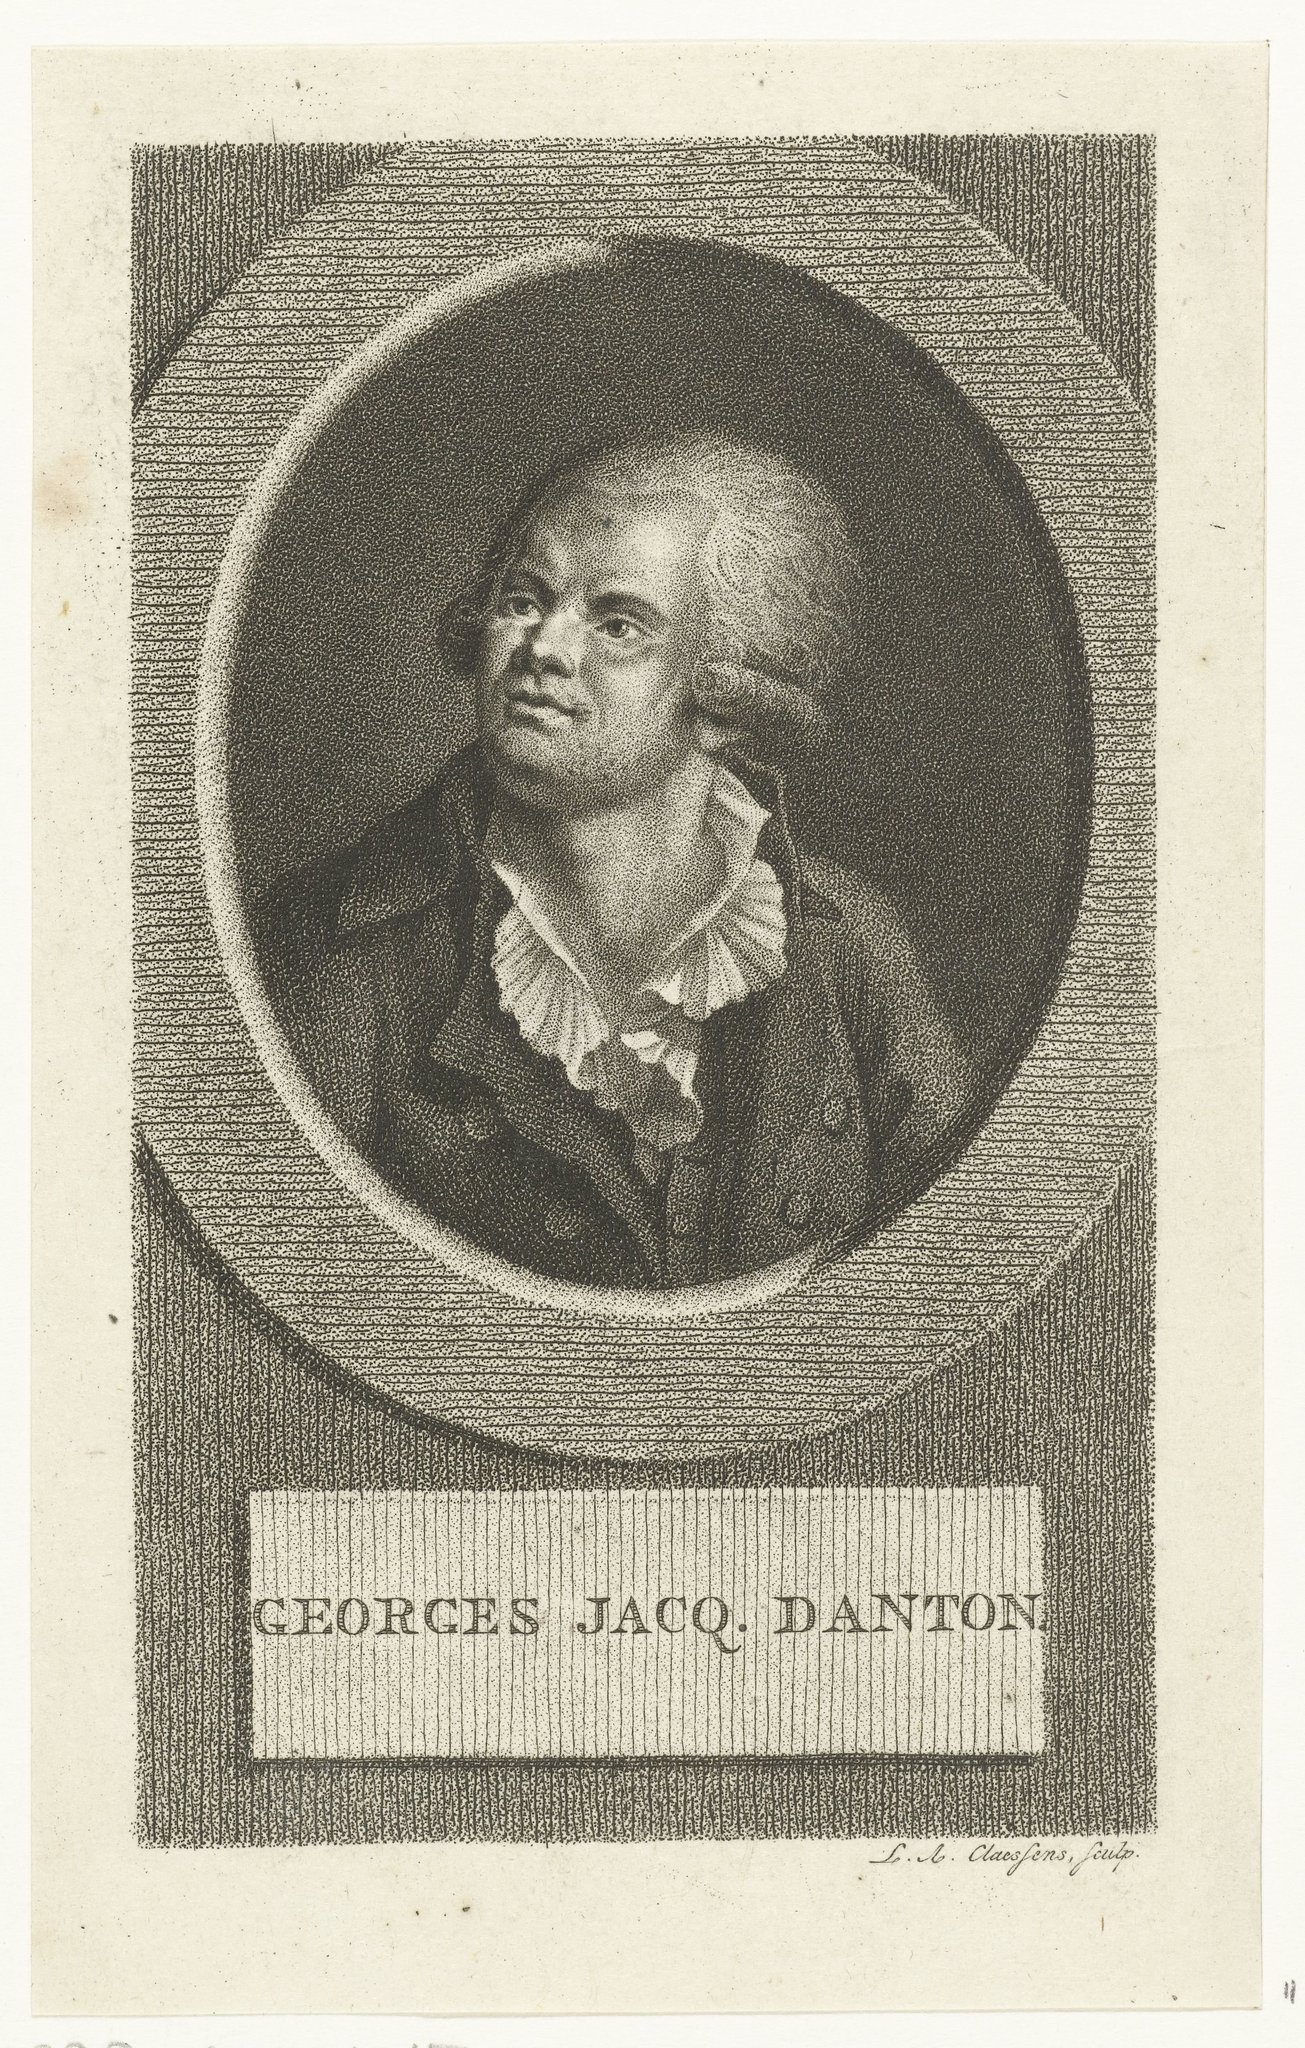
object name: print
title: Portret van Georges Jacques Danton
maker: lambertus antonius claessens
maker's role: draughtsman, print maker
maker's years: 1763-1834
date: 1792-1808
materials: paper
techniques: engraving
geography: amsterdam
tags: paris, politician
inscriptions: collector's mark: Lugt 2228